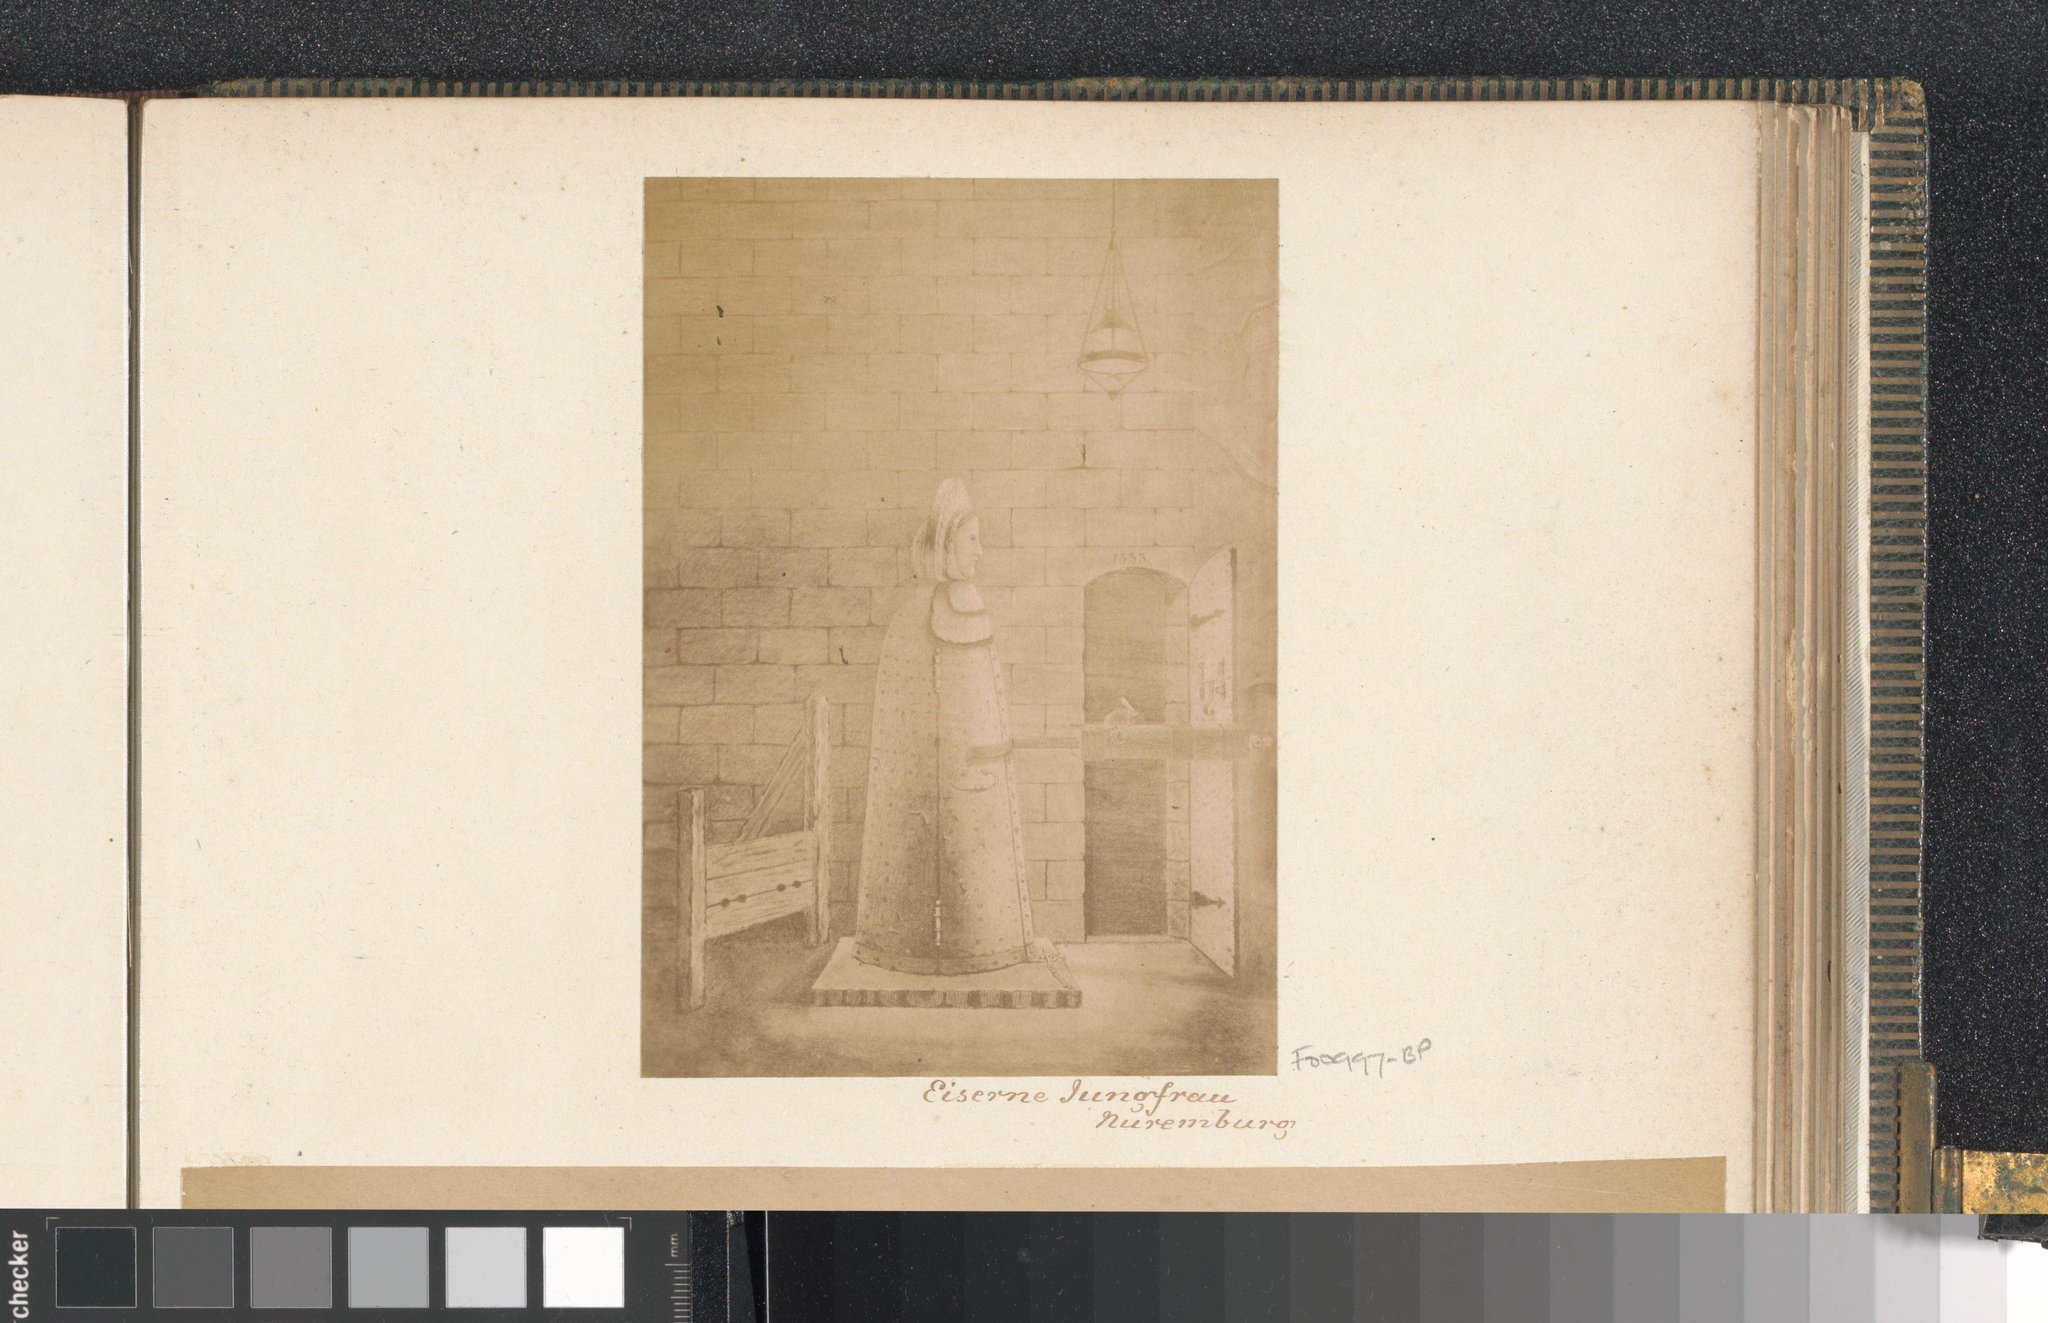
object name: reproduction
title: Fotoreproductie van (vermoedelijk) een tekening van de Eiserne Jungfrau (IJzeren Maagd) uit Neurenberg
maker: Anonymous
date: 1860-1890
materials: paper, photographic support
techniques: albumen print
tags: instruments of torture, execution or punishment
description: Onderdeel van Reisalbum met foto's van Zwitserland, Oostenrijk, Italië en Duitsland.